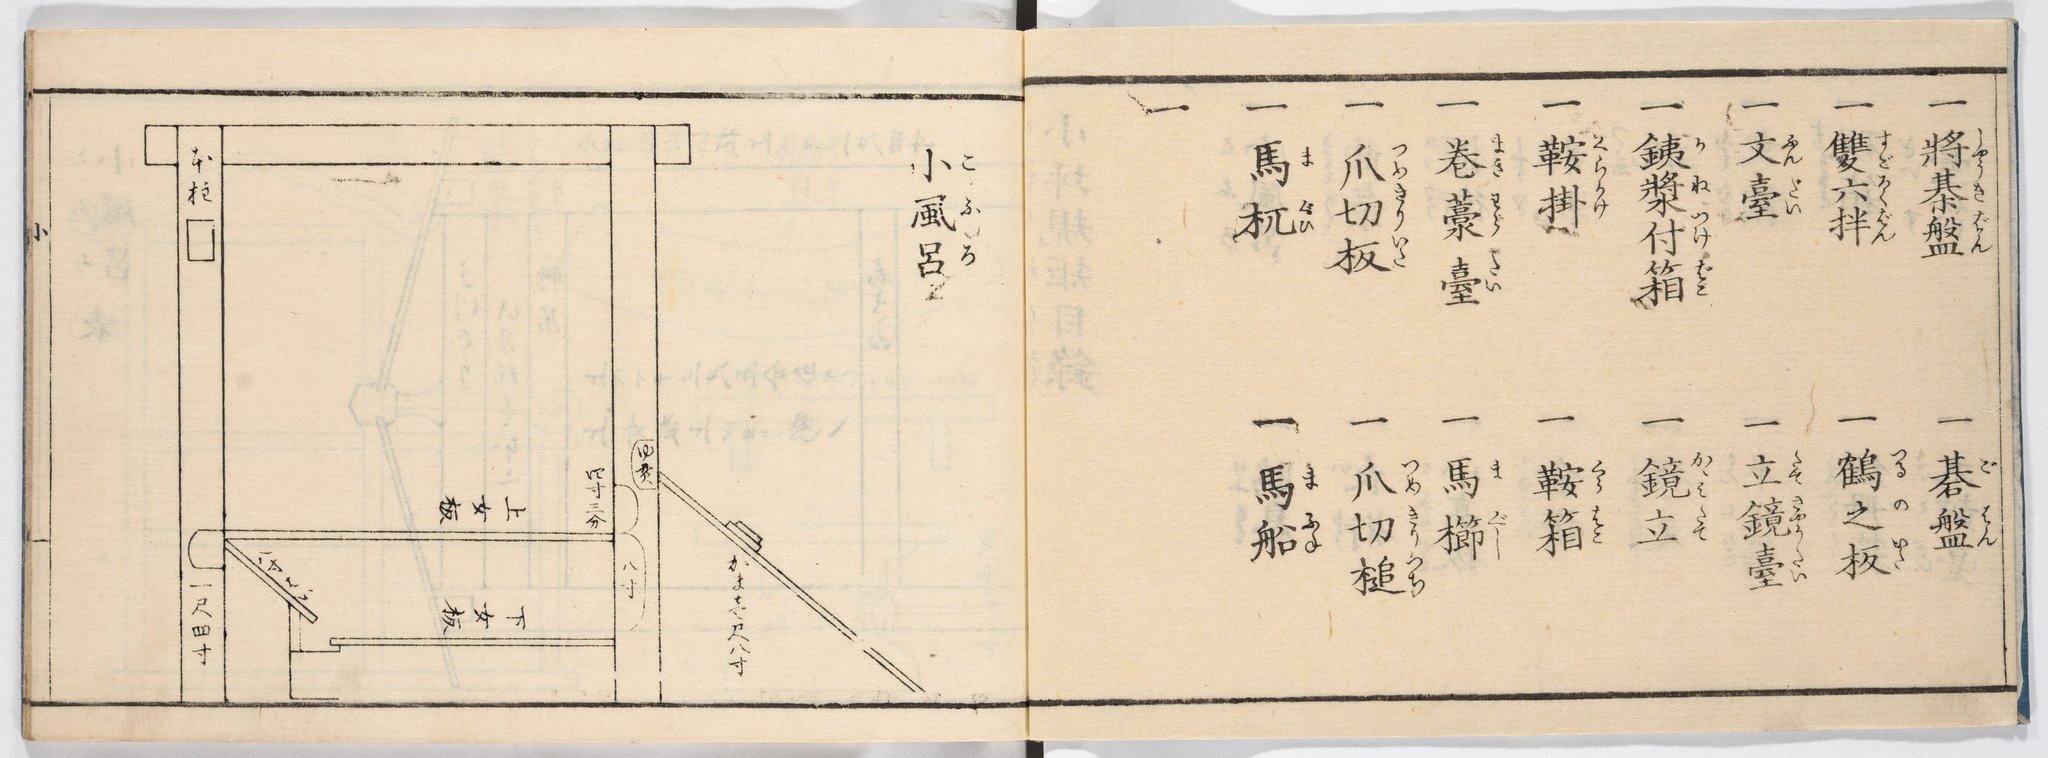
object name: illustrated book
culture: japanese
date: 1893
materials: ink, paper